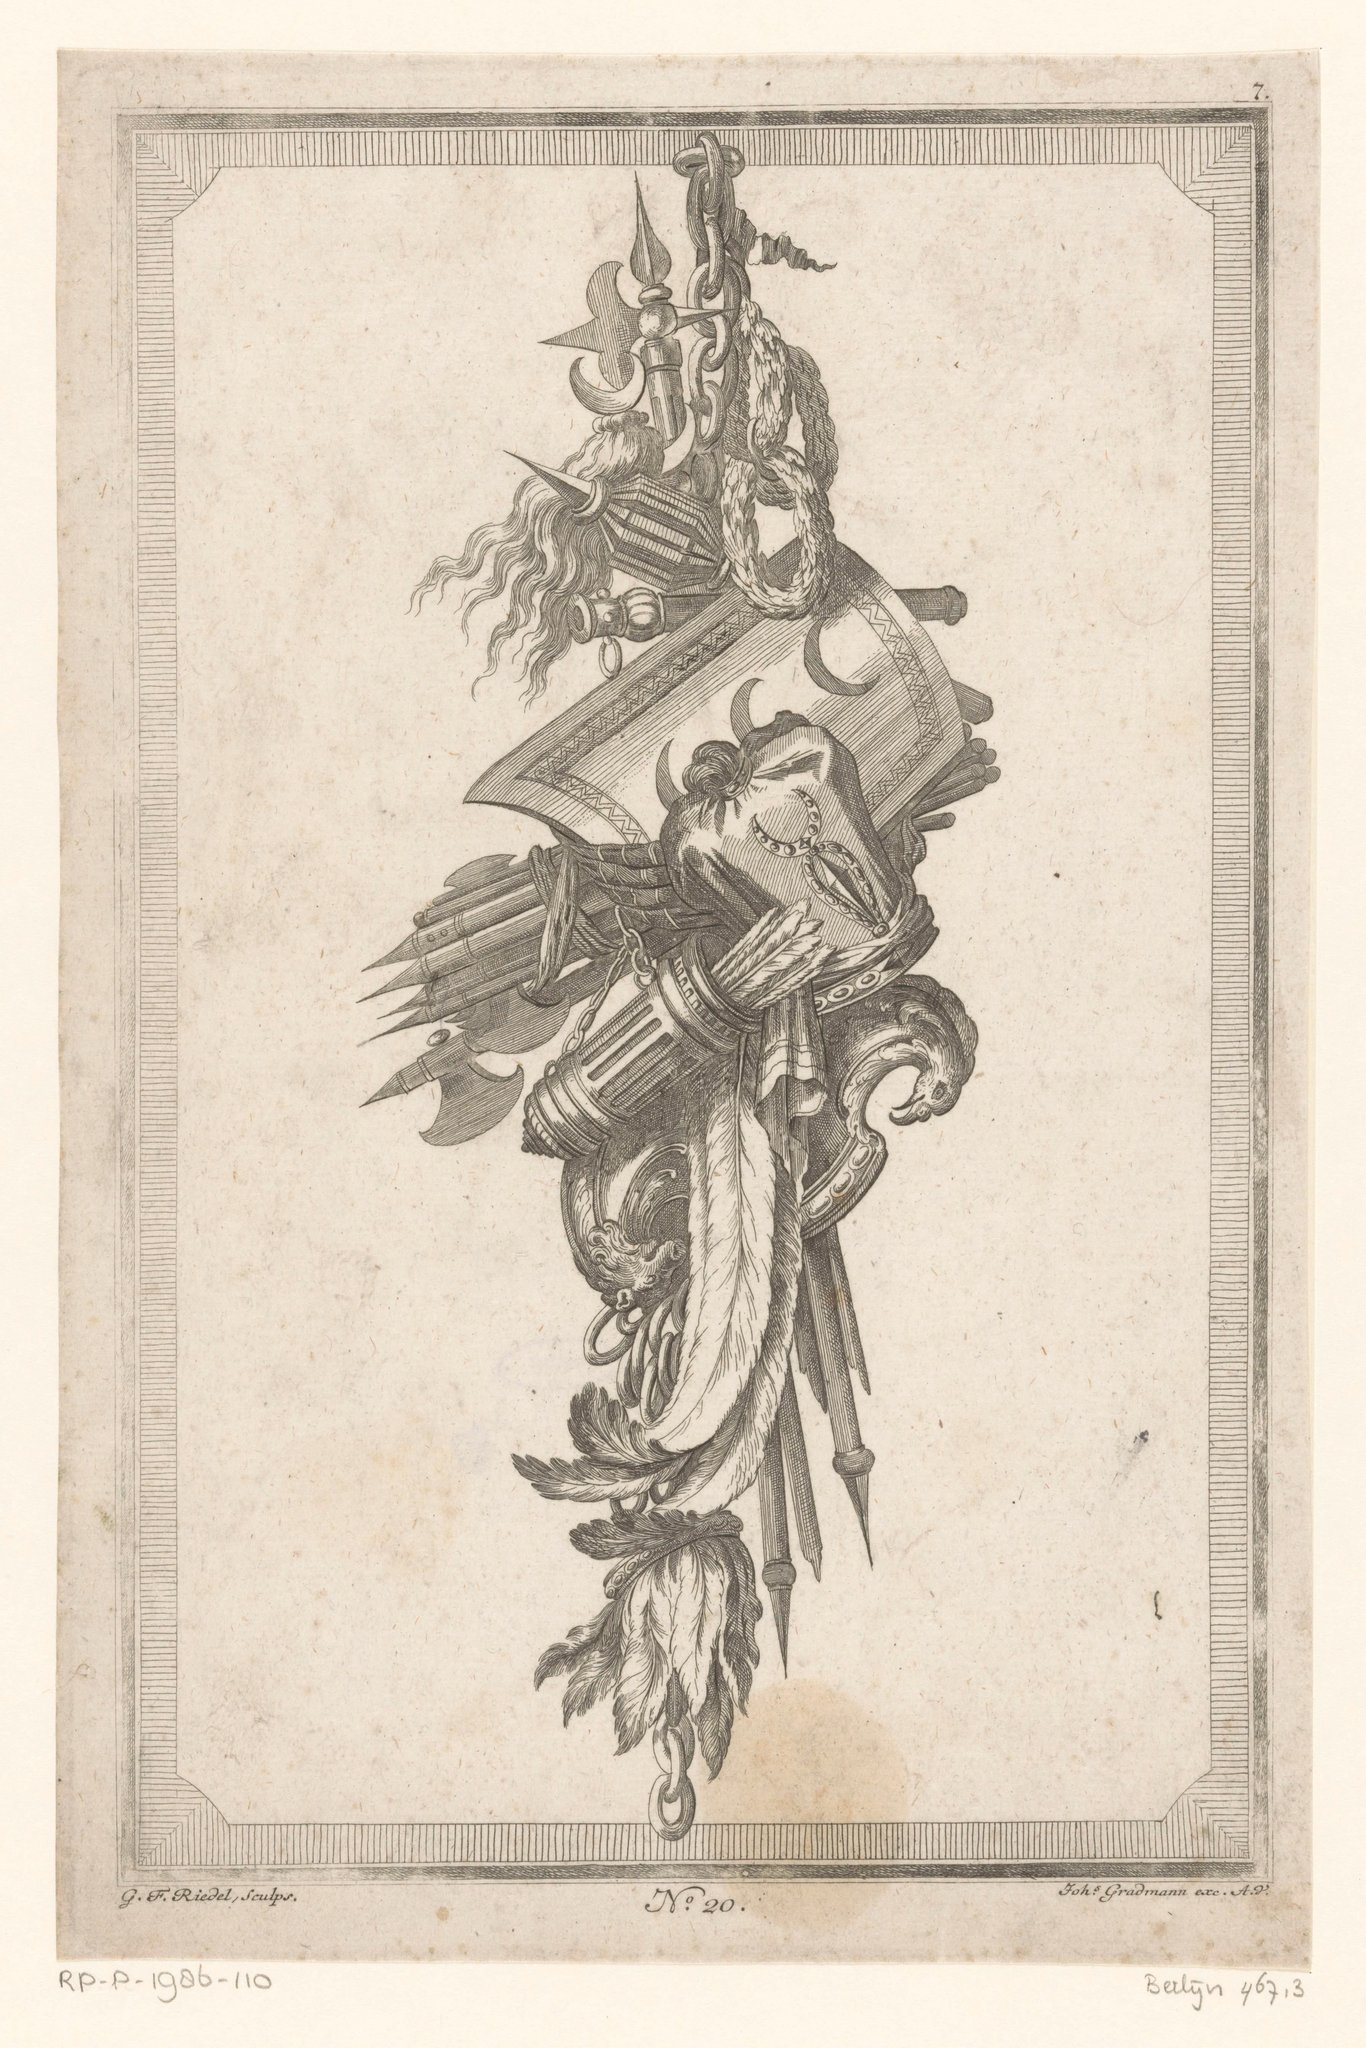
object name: ornament print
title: Trofee met schild en hoofddeksel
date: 1779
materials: paper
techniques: engraving, etching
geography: augsburg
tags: protective weapons: shield, trophy, i.e.: decorative arrangement of symbolic or typical objects ~ ornament, head-gear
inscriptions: collector's mark: Lugt 2760, collector's mark: Lugt 2228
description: Een trofee met wapens, een schild, een fasces, een hoofddeksel en een pijlenkoker. Uitgeversnummer 20.